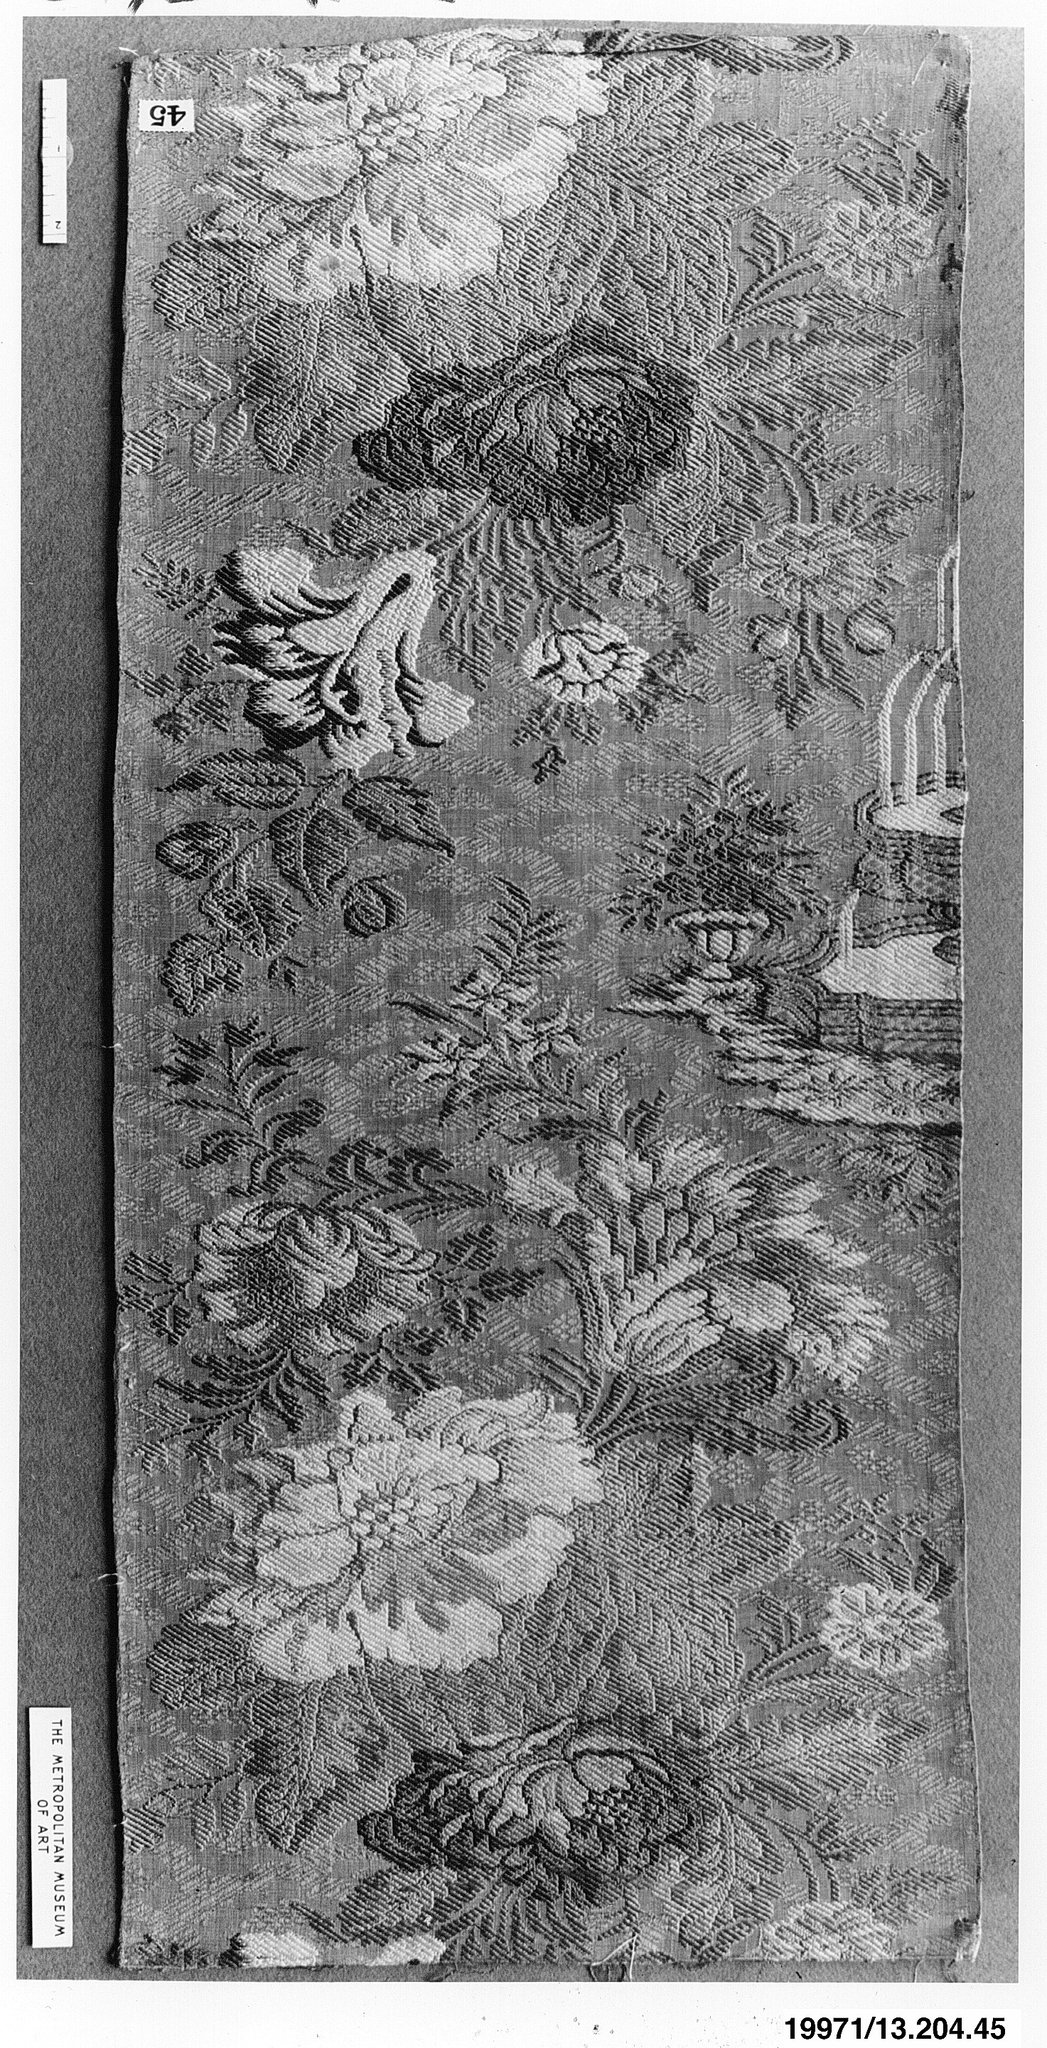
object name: piece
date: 1701-1733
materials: silk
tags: flowers,leaves